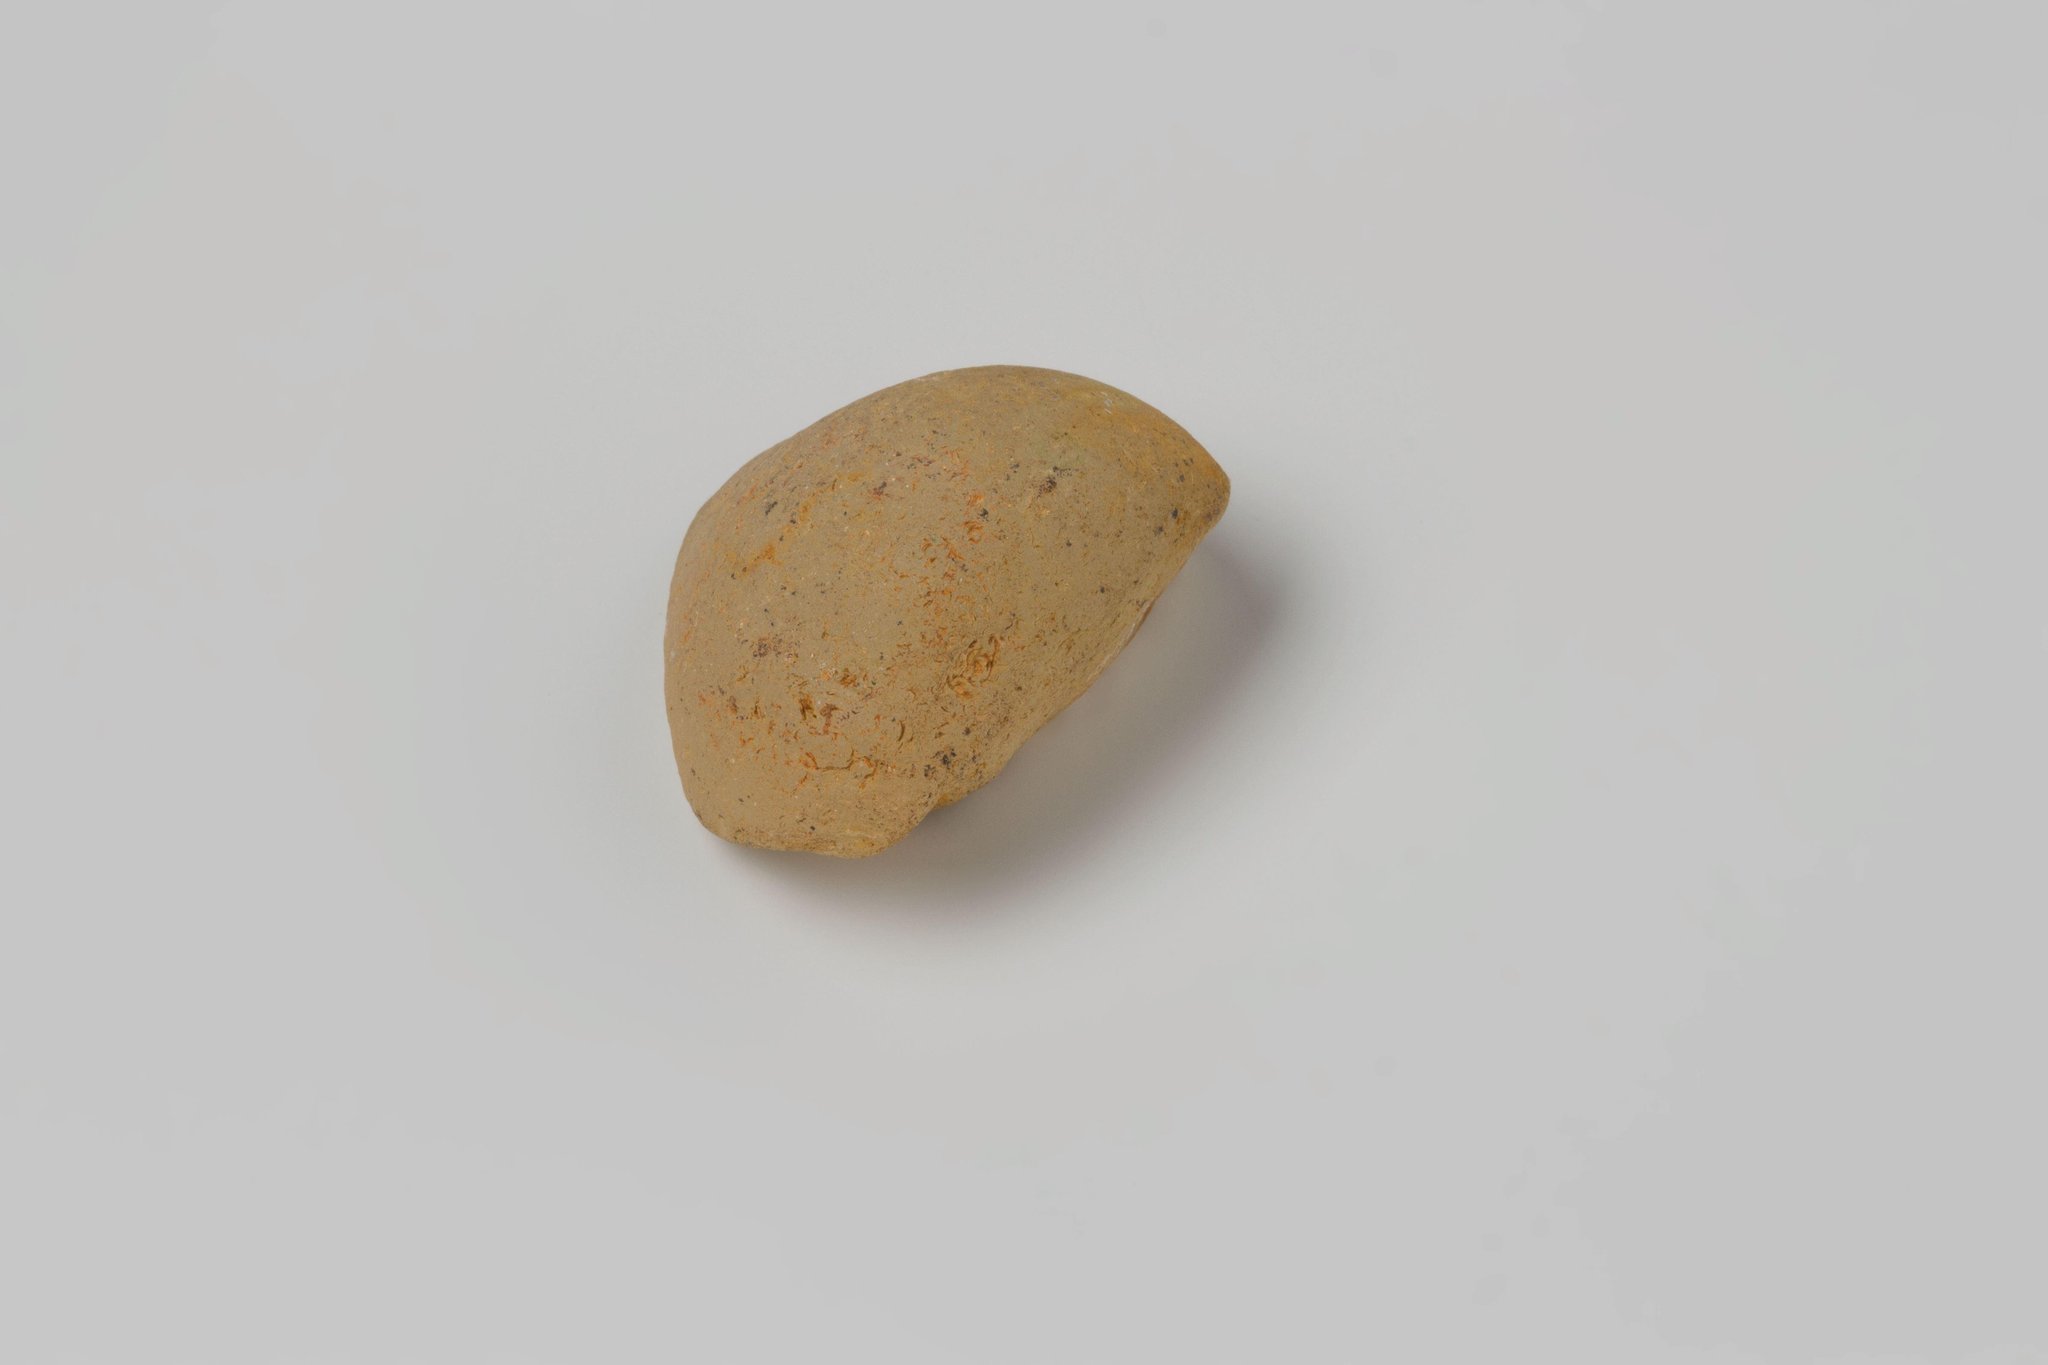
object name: flute glass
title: Fragment balustervormige steel van een fluitglas uit het wrak van de Oost-Indiëvaarder Hollandia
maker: Anonymous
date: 1700-1743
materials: glass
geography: netherlands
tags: verenigde oostindische compagnie, hollandia (schip), annet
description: Glass, stem glass, steel, baluster-shaped; fragment of pear-shaped knop, eroded.